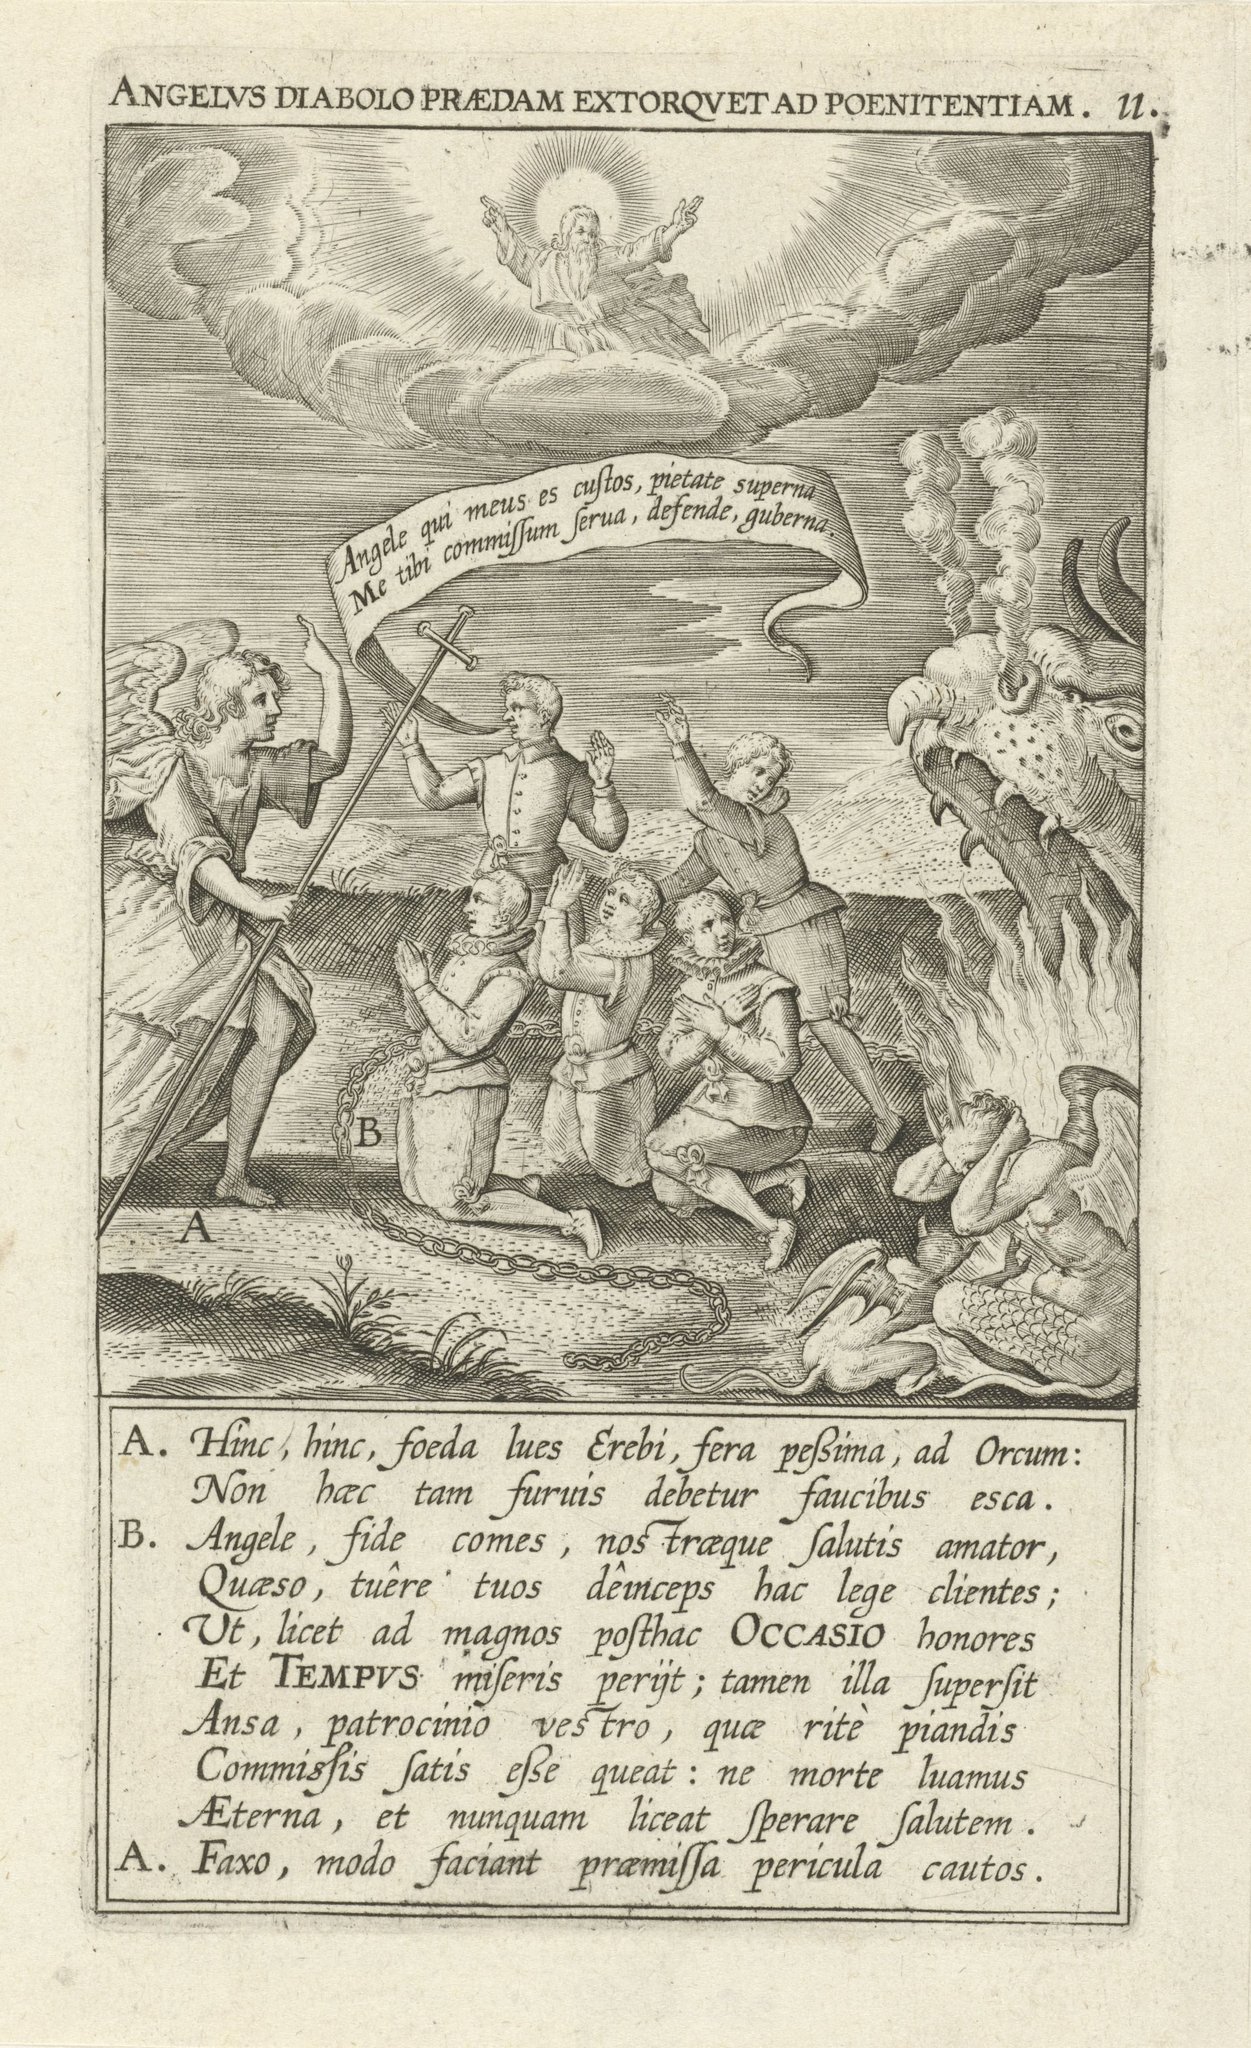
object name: print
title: Angelvs diabolo praedam extorqvet ad poenitentiam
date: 1603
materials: paper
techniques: engraving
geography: antwerp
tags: angels rescuing a soul pursued by devils, god the father, youth, adolescent, entrance of hell as monstrous mouth (of leviathan), man as sinner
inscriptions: collector's mark: Lugt 2228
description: Voor de hellemond smeken de vijf zondige jongeren de engel van het Geloof om vergeving van hun zonden. Centraal bovenaan God in de hemel. De prent heeft een Latijns onderschrift met legende en maakt deel uit van een 12-delige serie over het benutten van kansen.